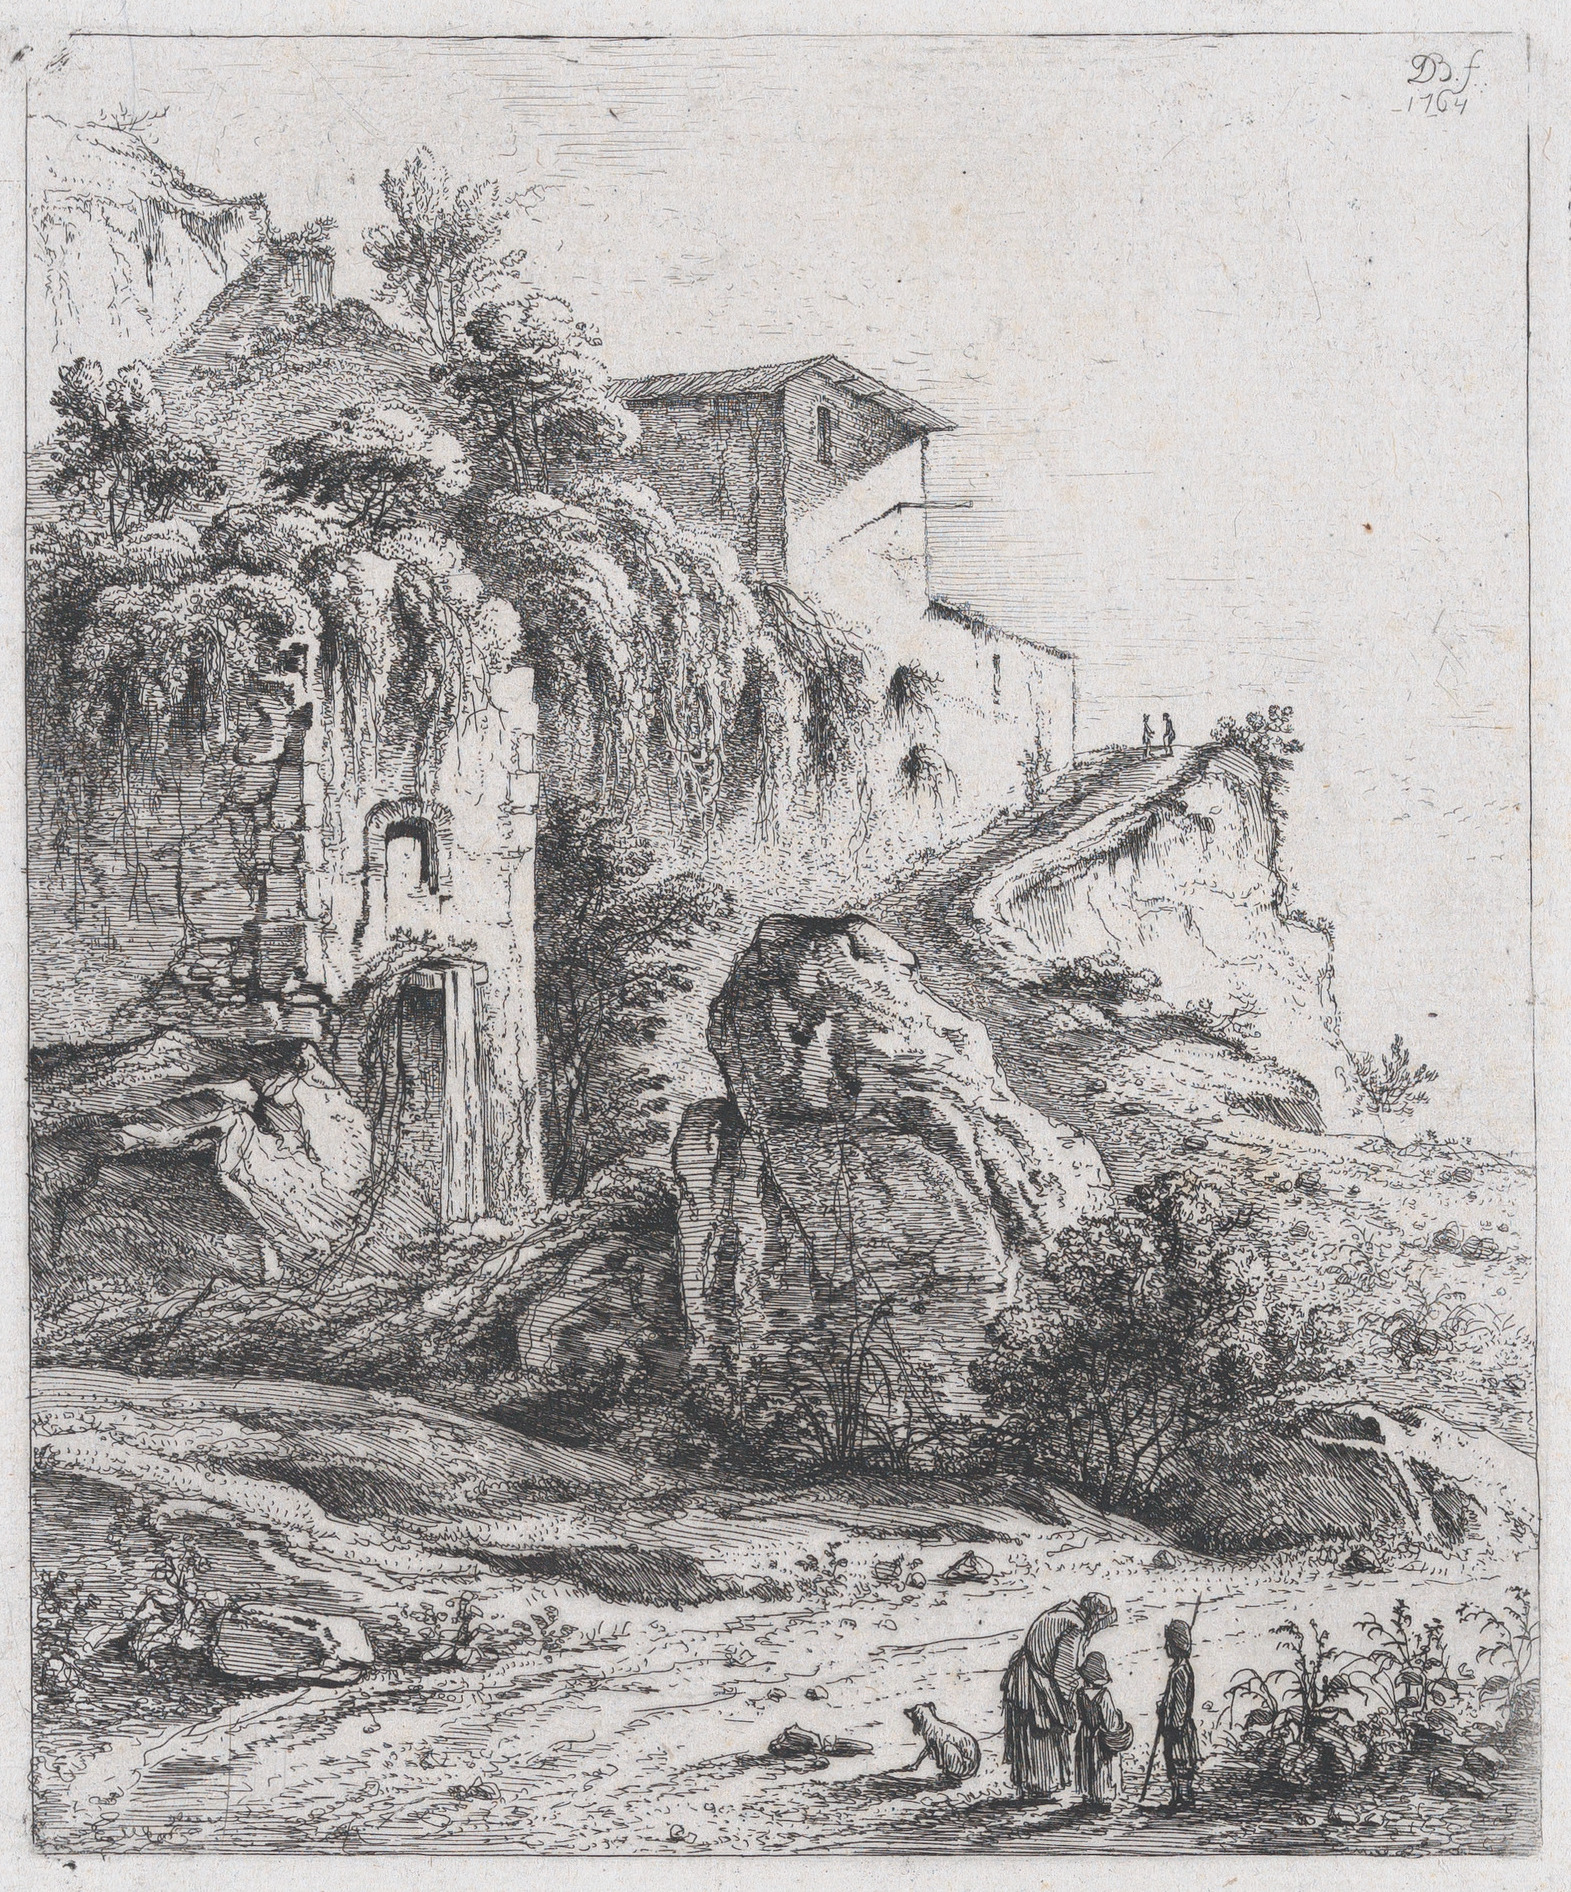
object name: print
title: The Fountain of Choulans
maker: jean jacques de boissieu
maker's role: artist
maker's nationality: french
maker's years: 1736-1810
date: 1764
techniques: drypoint, etching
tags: buildings